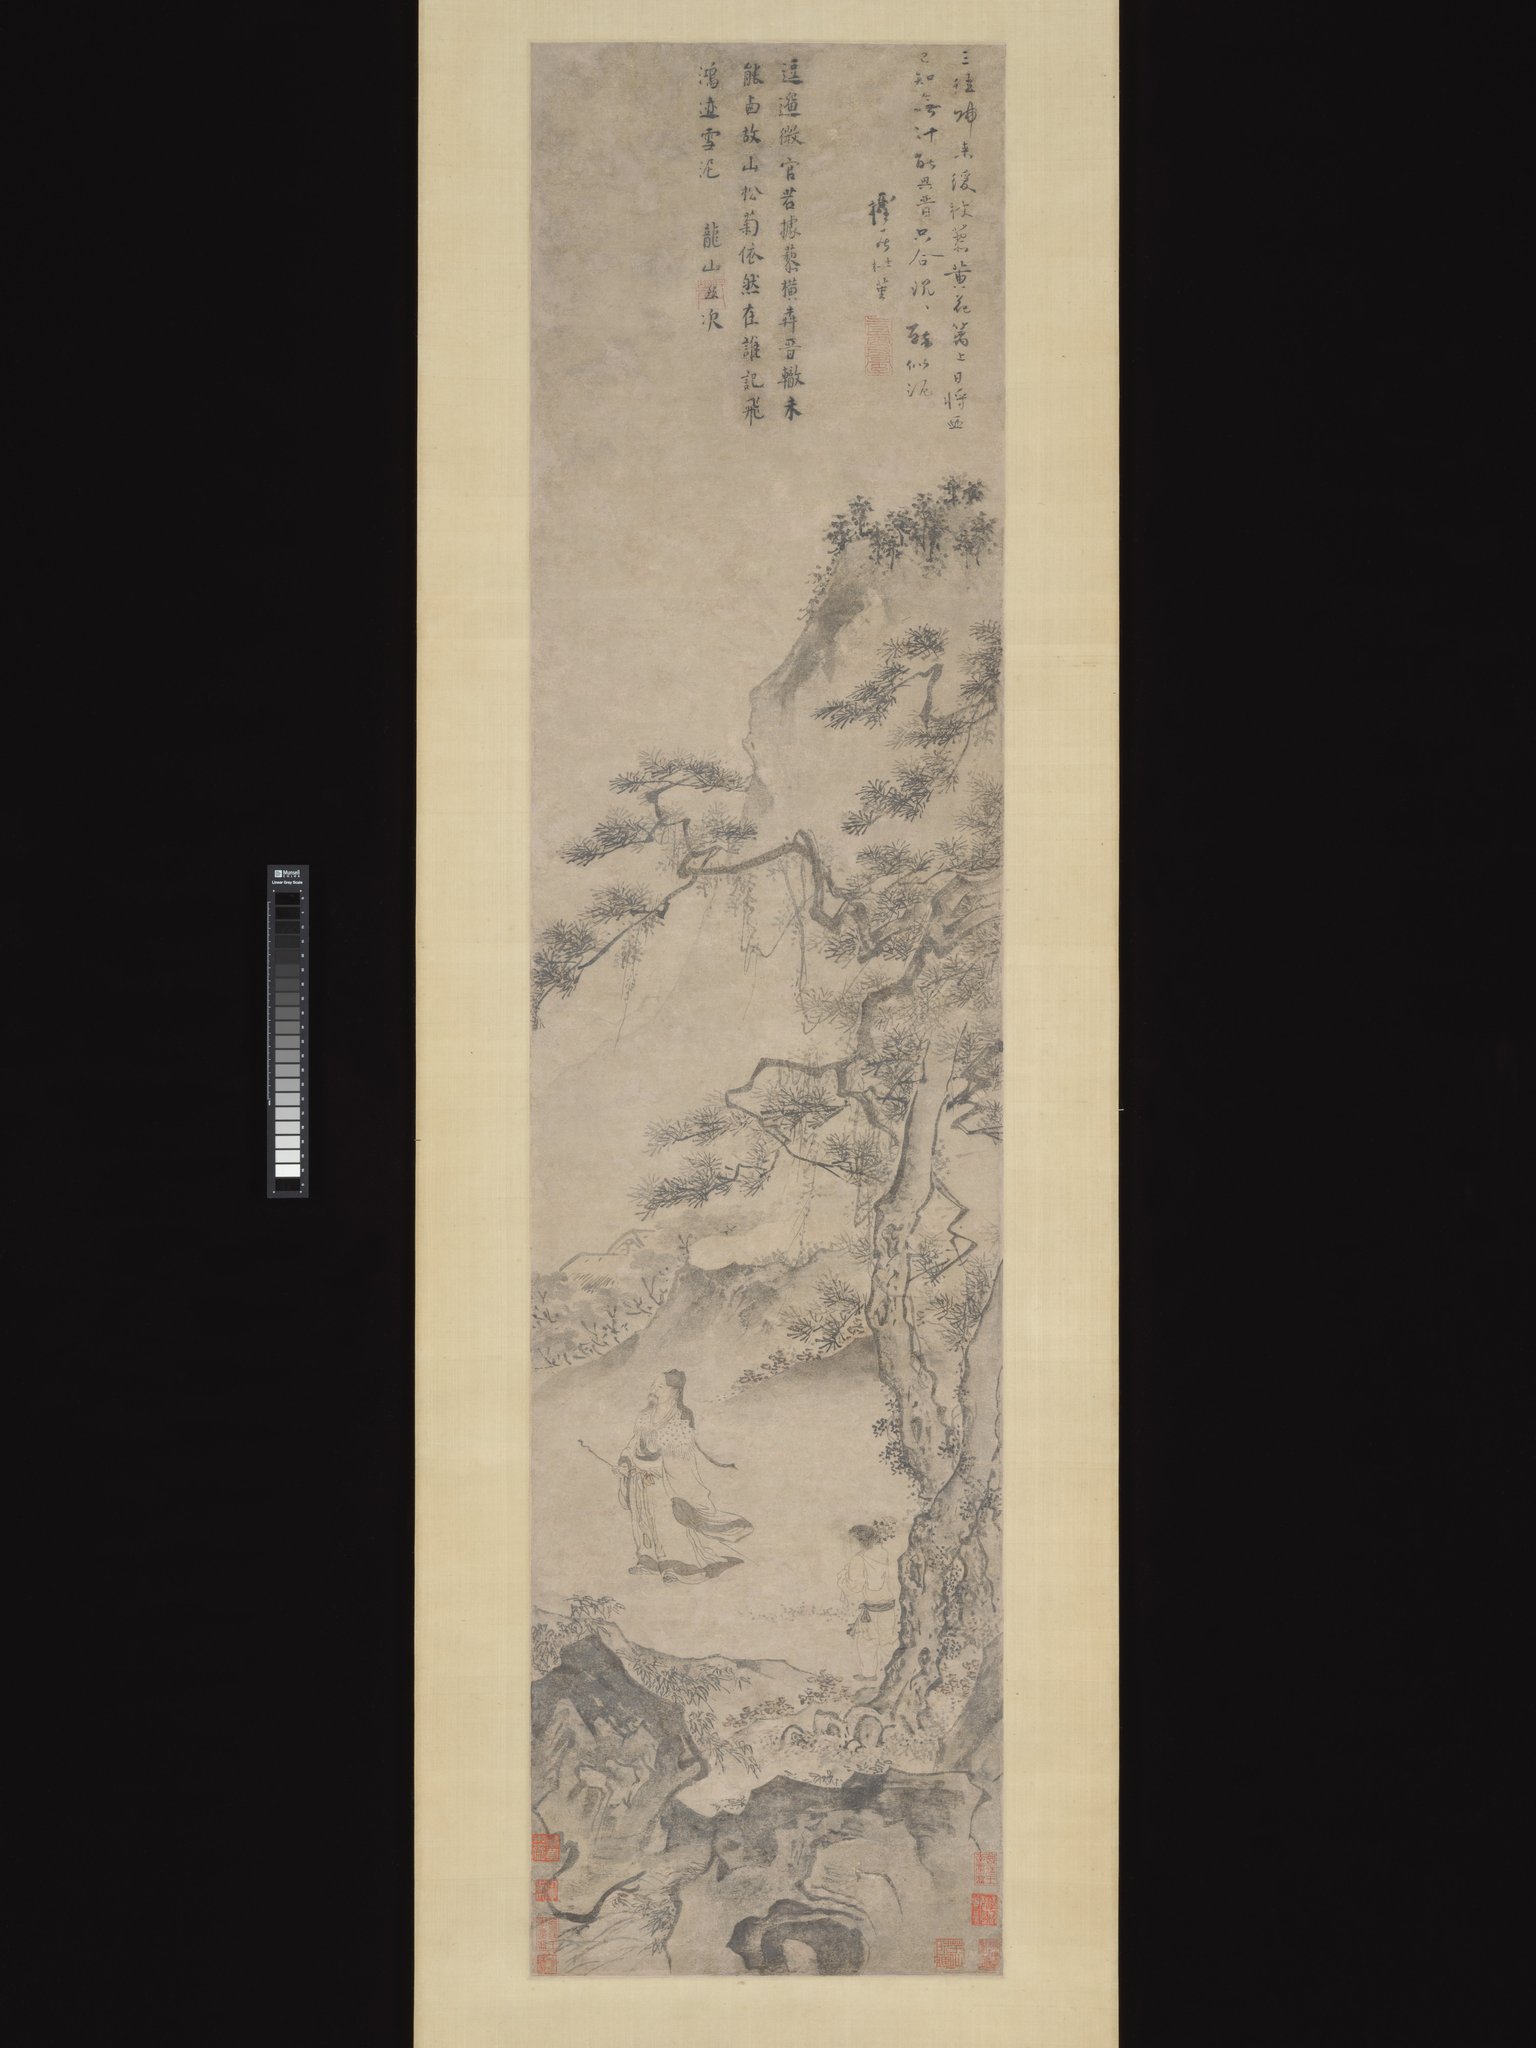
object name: hanging scroll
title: Tao Yuanming enjoying chrysanthemums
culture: chinese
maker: du jin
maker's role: artist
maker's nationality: chinese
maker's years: 1465-1509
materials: ink, paper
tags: men,landscapes,trees